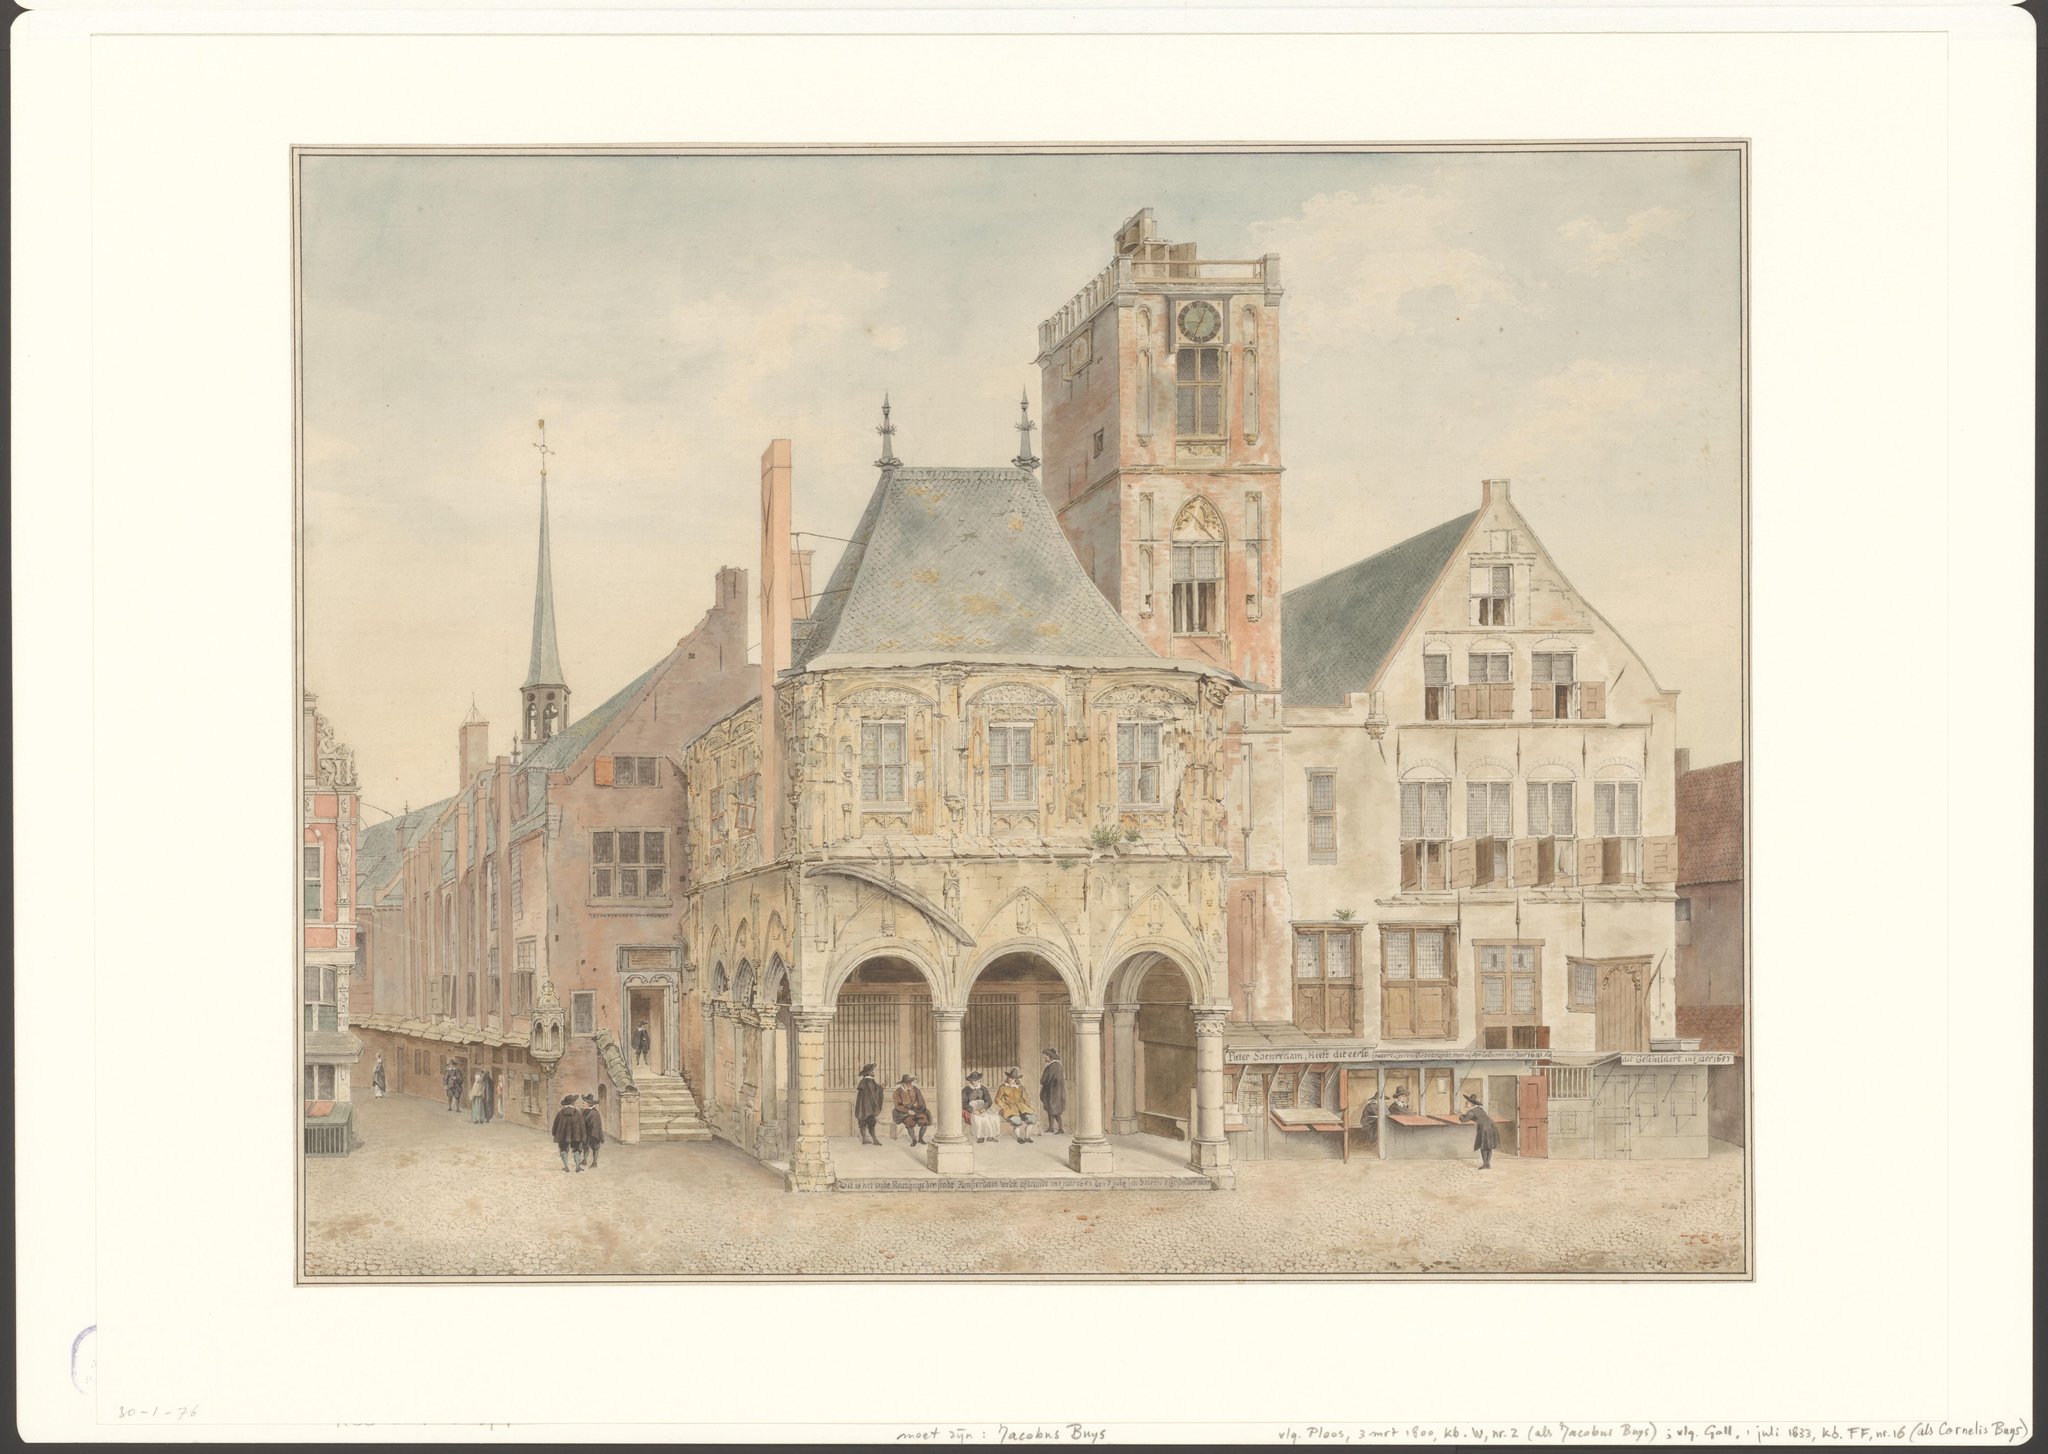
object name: drawing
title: Gezicht op het oude stadhuis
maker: pieter jansz saenredam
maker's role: draughtsman, painter, print maker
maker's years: 1597-1665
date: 1734-1801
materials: ink, paper, pencil, watercolor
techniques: brush, pen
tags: city-view in general; 'veduta', townhall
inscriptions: collector's mark: ‘15’ Lugt 1641b, inscription: ‘h. 13 d / b. 19 1/2 / No 4098’, check stamp: Lugt 2034, inscription: ‘moet zijn: Jacobus Buys / vlg. Ploos, 3 mrt 1800, kb. W, nr. 2 (als Jacobus Buys); vlg. Gall, 1 juli 1833, kb. FF, nr. 16 (als Cornelis Buys)’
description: Onderwerpsrubriek binnen de Atlas Amsterdam: Oude Stadhuis, Oude Stadhuis op den Dam.